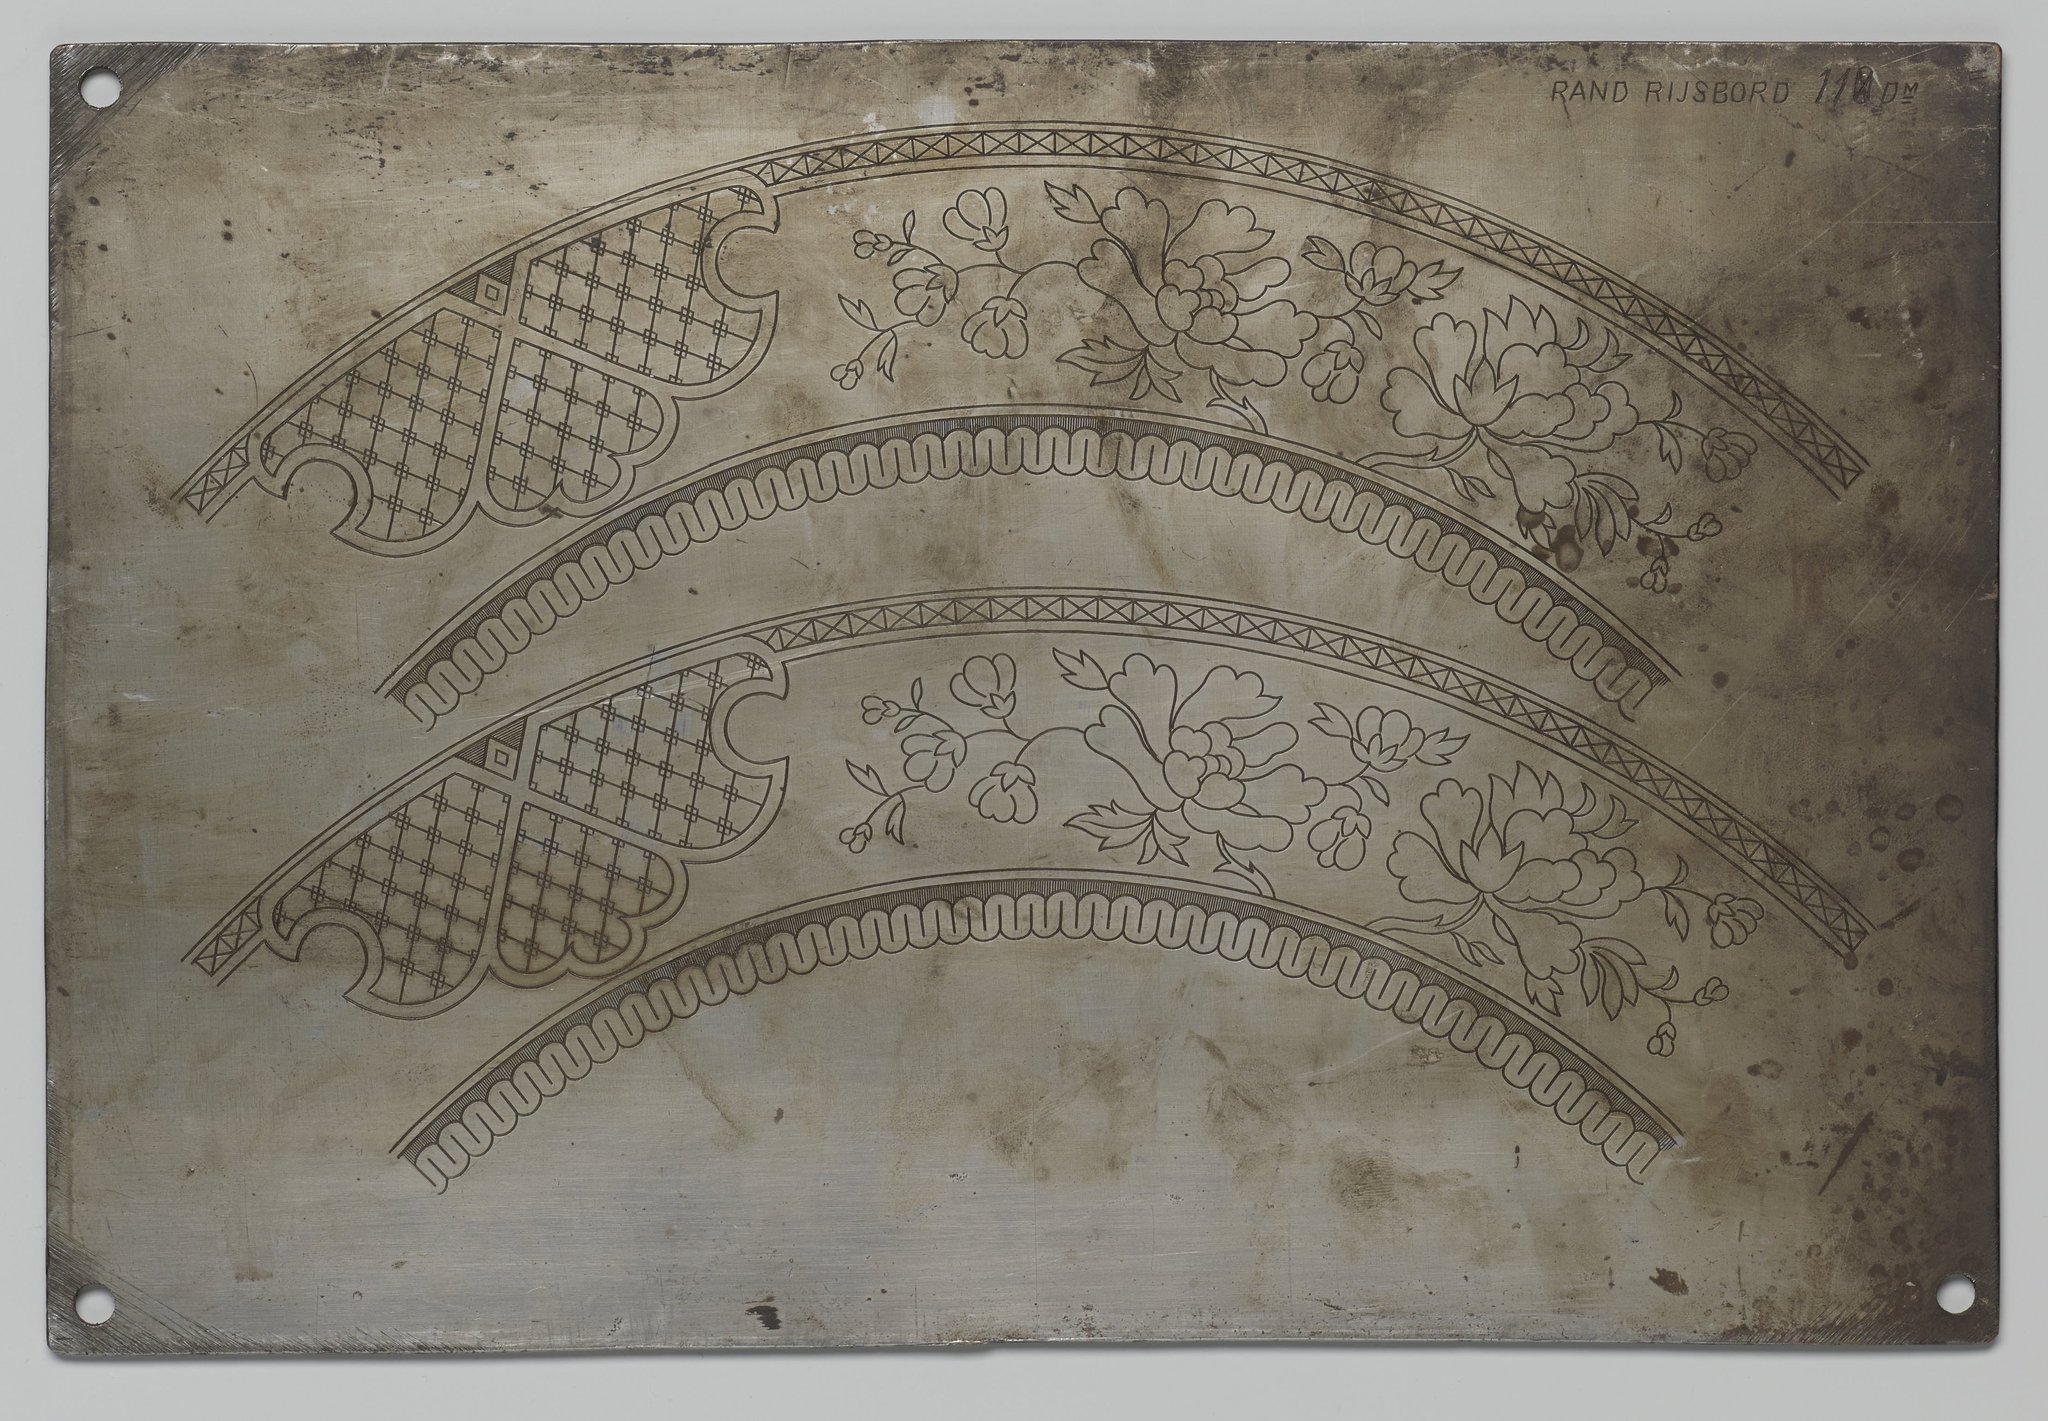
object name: plate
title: Plaat met gegraveerde decoraties voor een aardewerken bord met het decor ORIENTAL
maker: petrus regout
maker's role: plateelbakker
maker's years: 1801-1879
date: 1801-1879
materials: copper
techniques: engraving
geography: maastricht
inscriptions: inscription: ‘3308 en 110 (doorgehaald)’, inscription: ‘BORD R 8 Dm’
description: Plaat van koper met gegraveerde voorstellingen voor een bord met het decor ORIENTAL, en de bijbehorende fabrieksstempels. Rechts boven de tekst: BORD R 8 Dm. De achterzijde van de plaat vertoont een doorslag van de afbeelding op de voorzijde. In de rechter bovenhoek het nummer 3308 en het nummer 110 (doorgehaald).